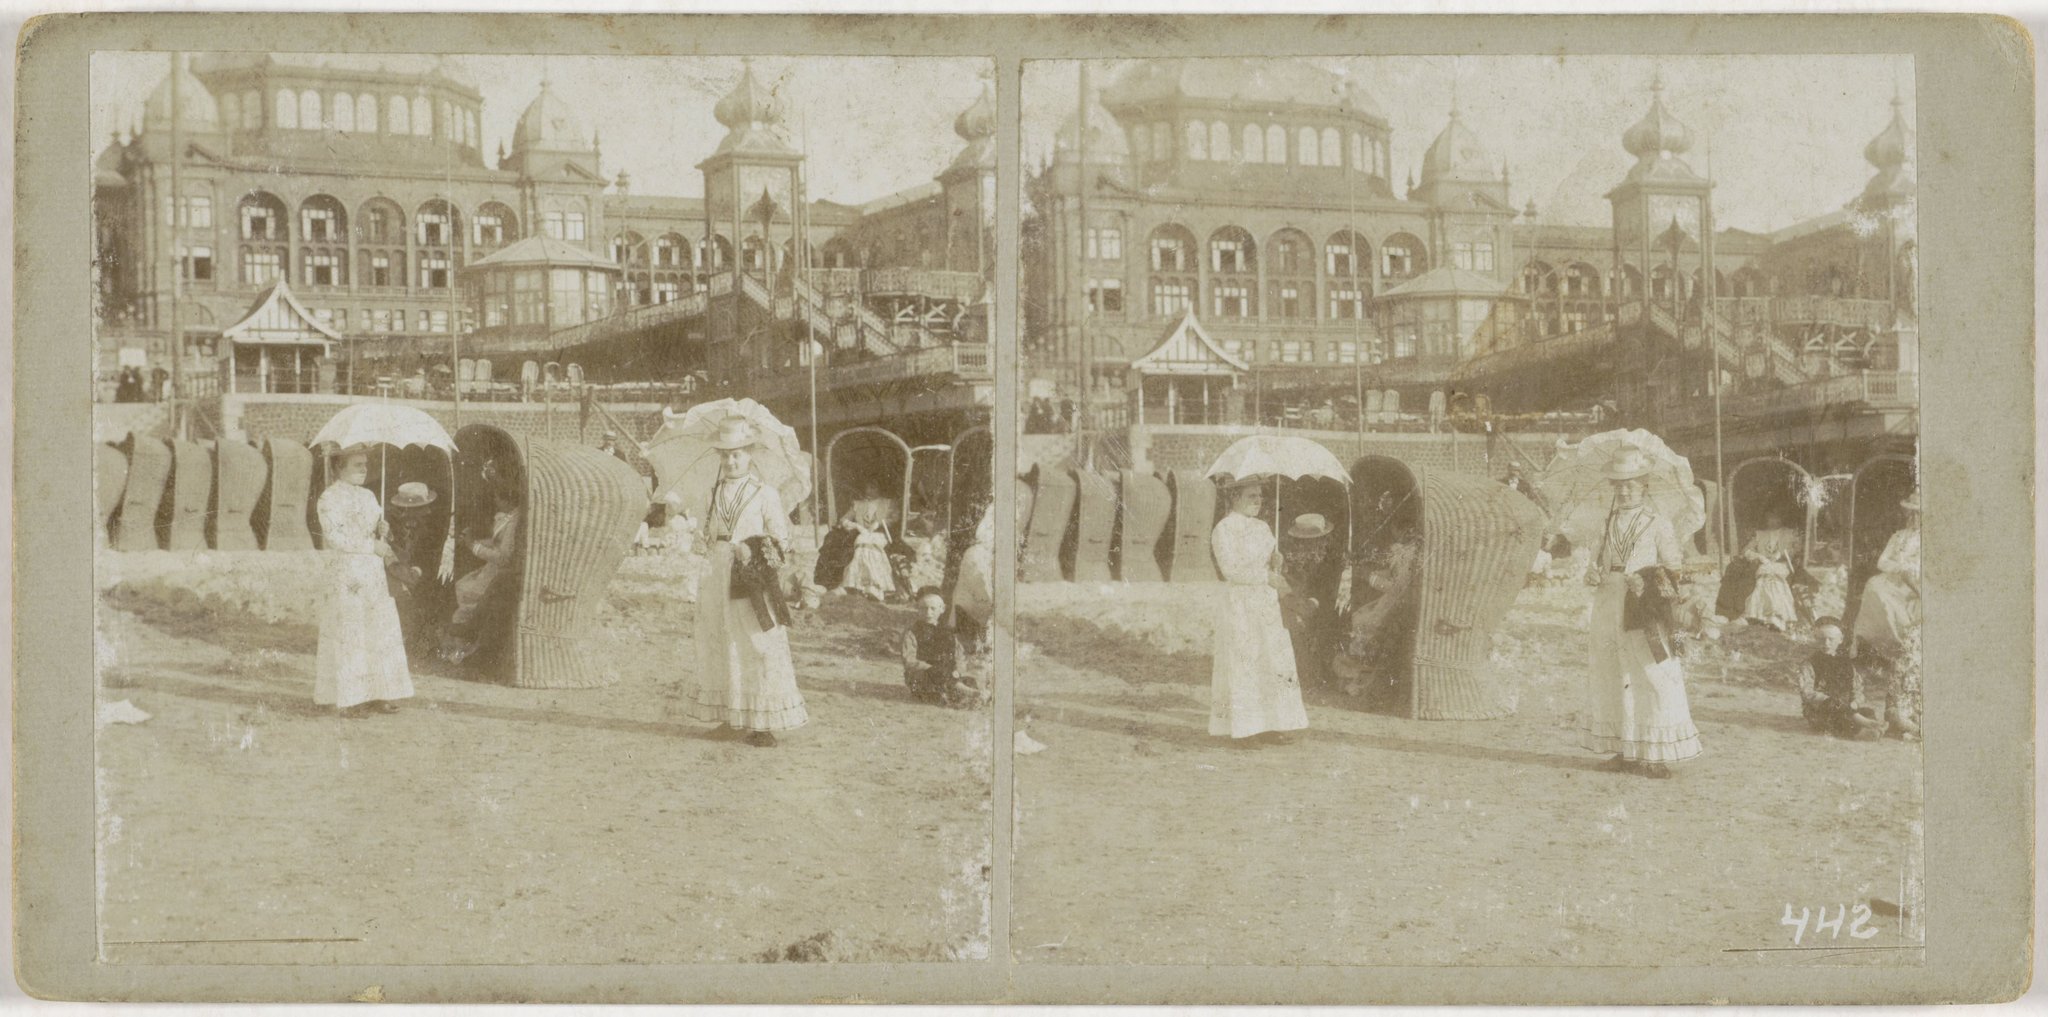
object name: stereograph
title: Taferelen op het Scheveningse strand met op de achtergrond het Kurhaus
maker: wilhelm frederick antonius delboy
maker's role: fotograaf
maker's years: 1853-1928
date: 1890-1910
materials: cardboard, photographic support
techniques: collodion silver print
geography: scheveningen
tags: beach (as place of recreation), recreation, hotel, hostelry, inn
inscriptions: number: ‘442’, address: ‘DELBOIJ/ Fotograaf/ Passage 22/ DEN HAAG.’